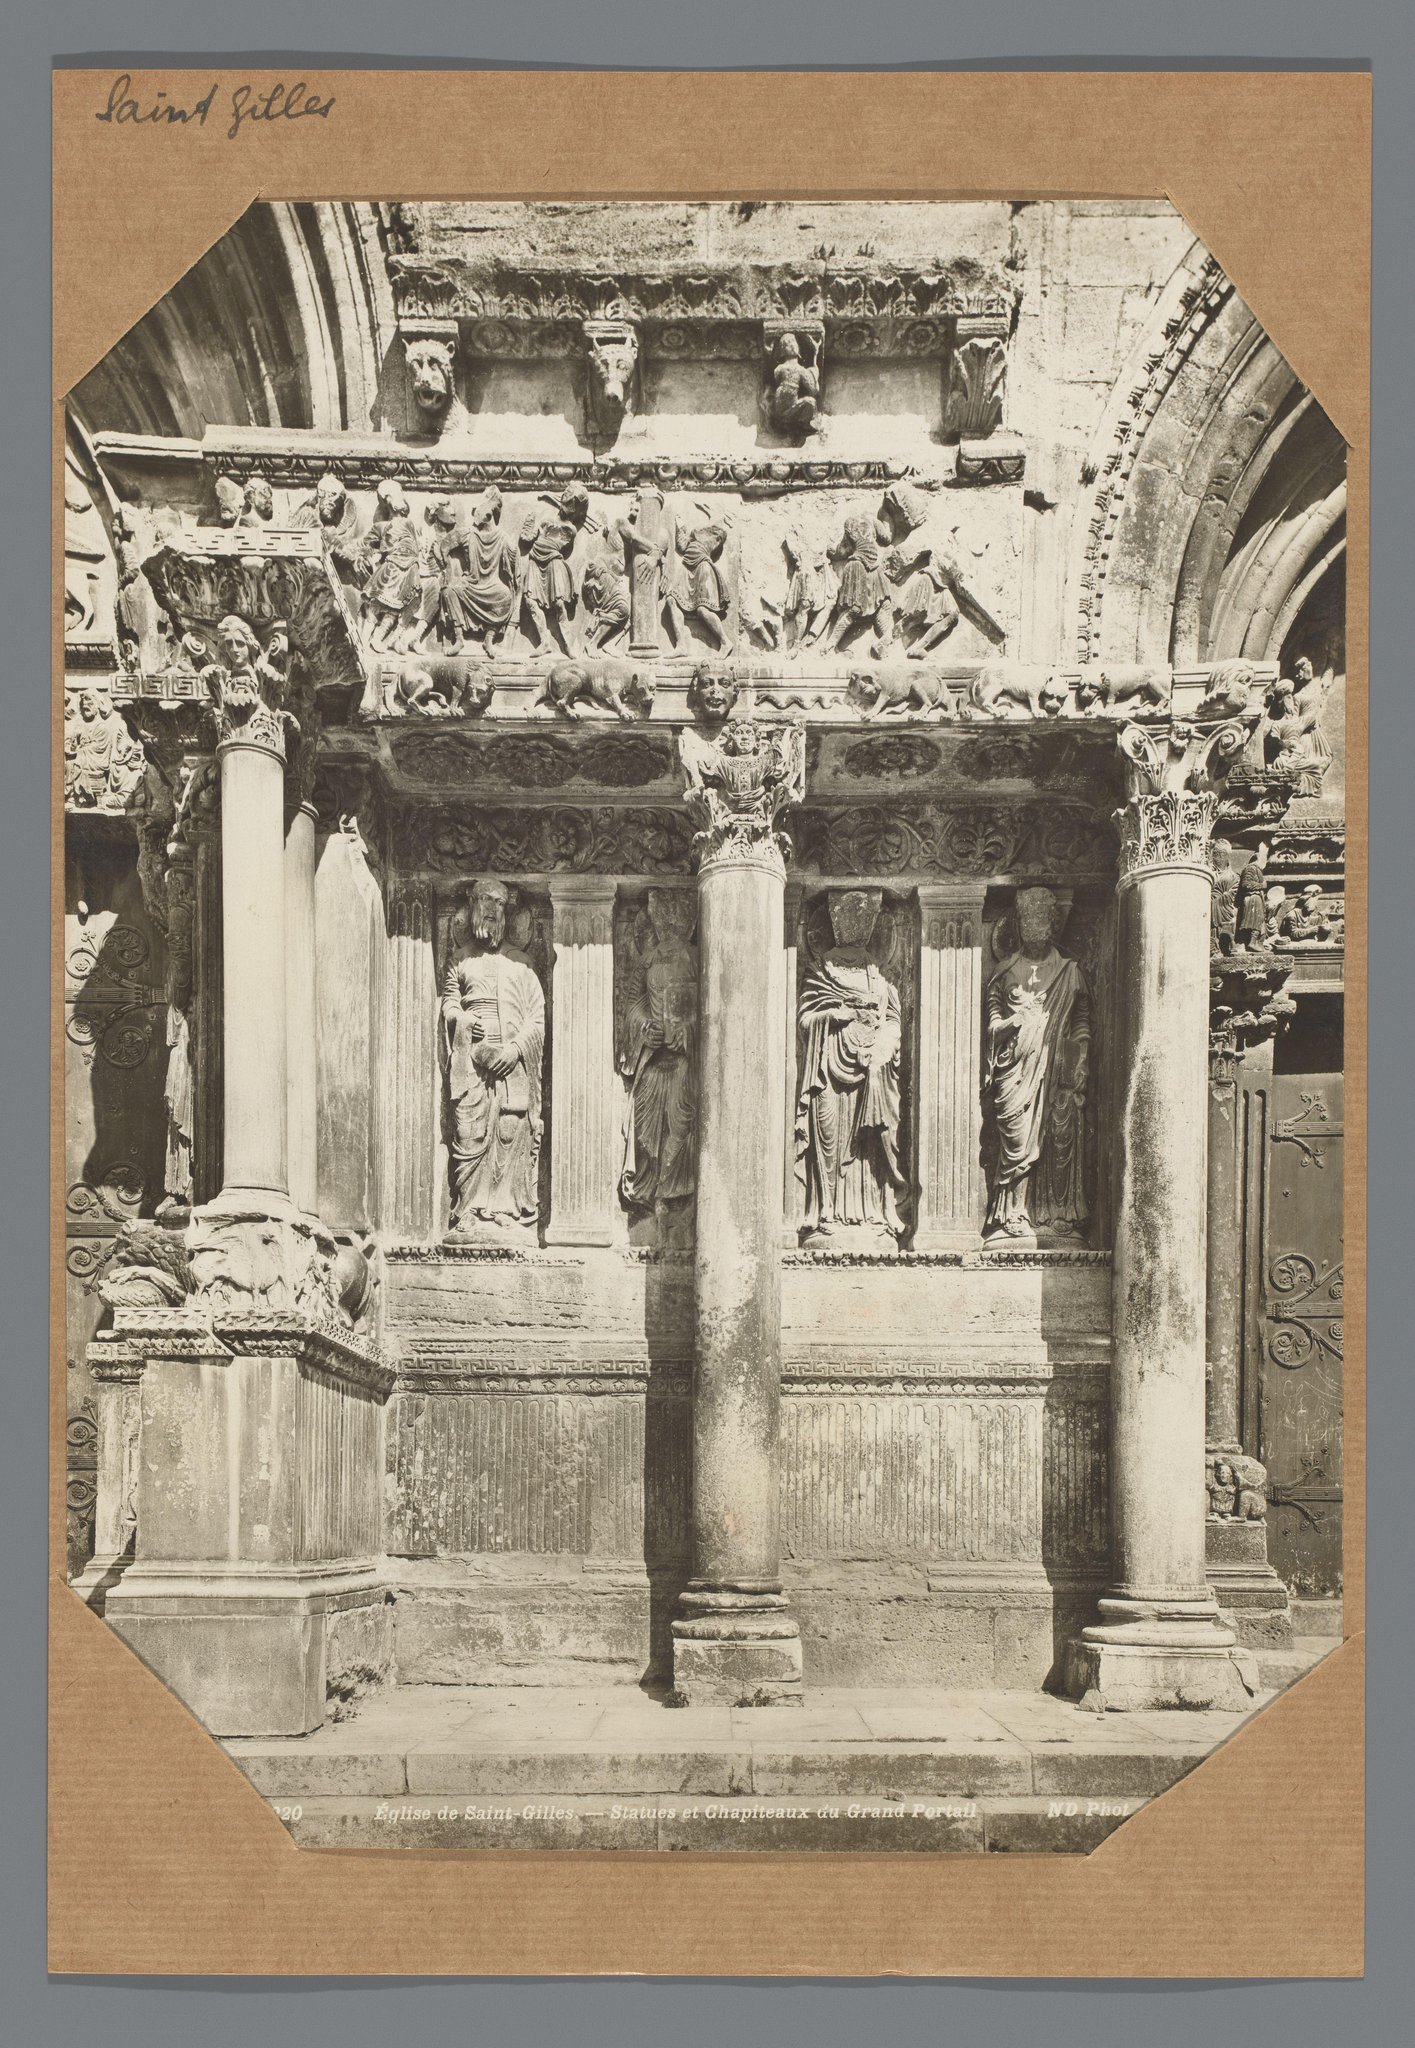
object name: photograph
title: Saint-Gilles, Kirche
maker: Anonymous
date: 1880-1930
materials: photographic support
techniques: gelatin silver print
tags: france